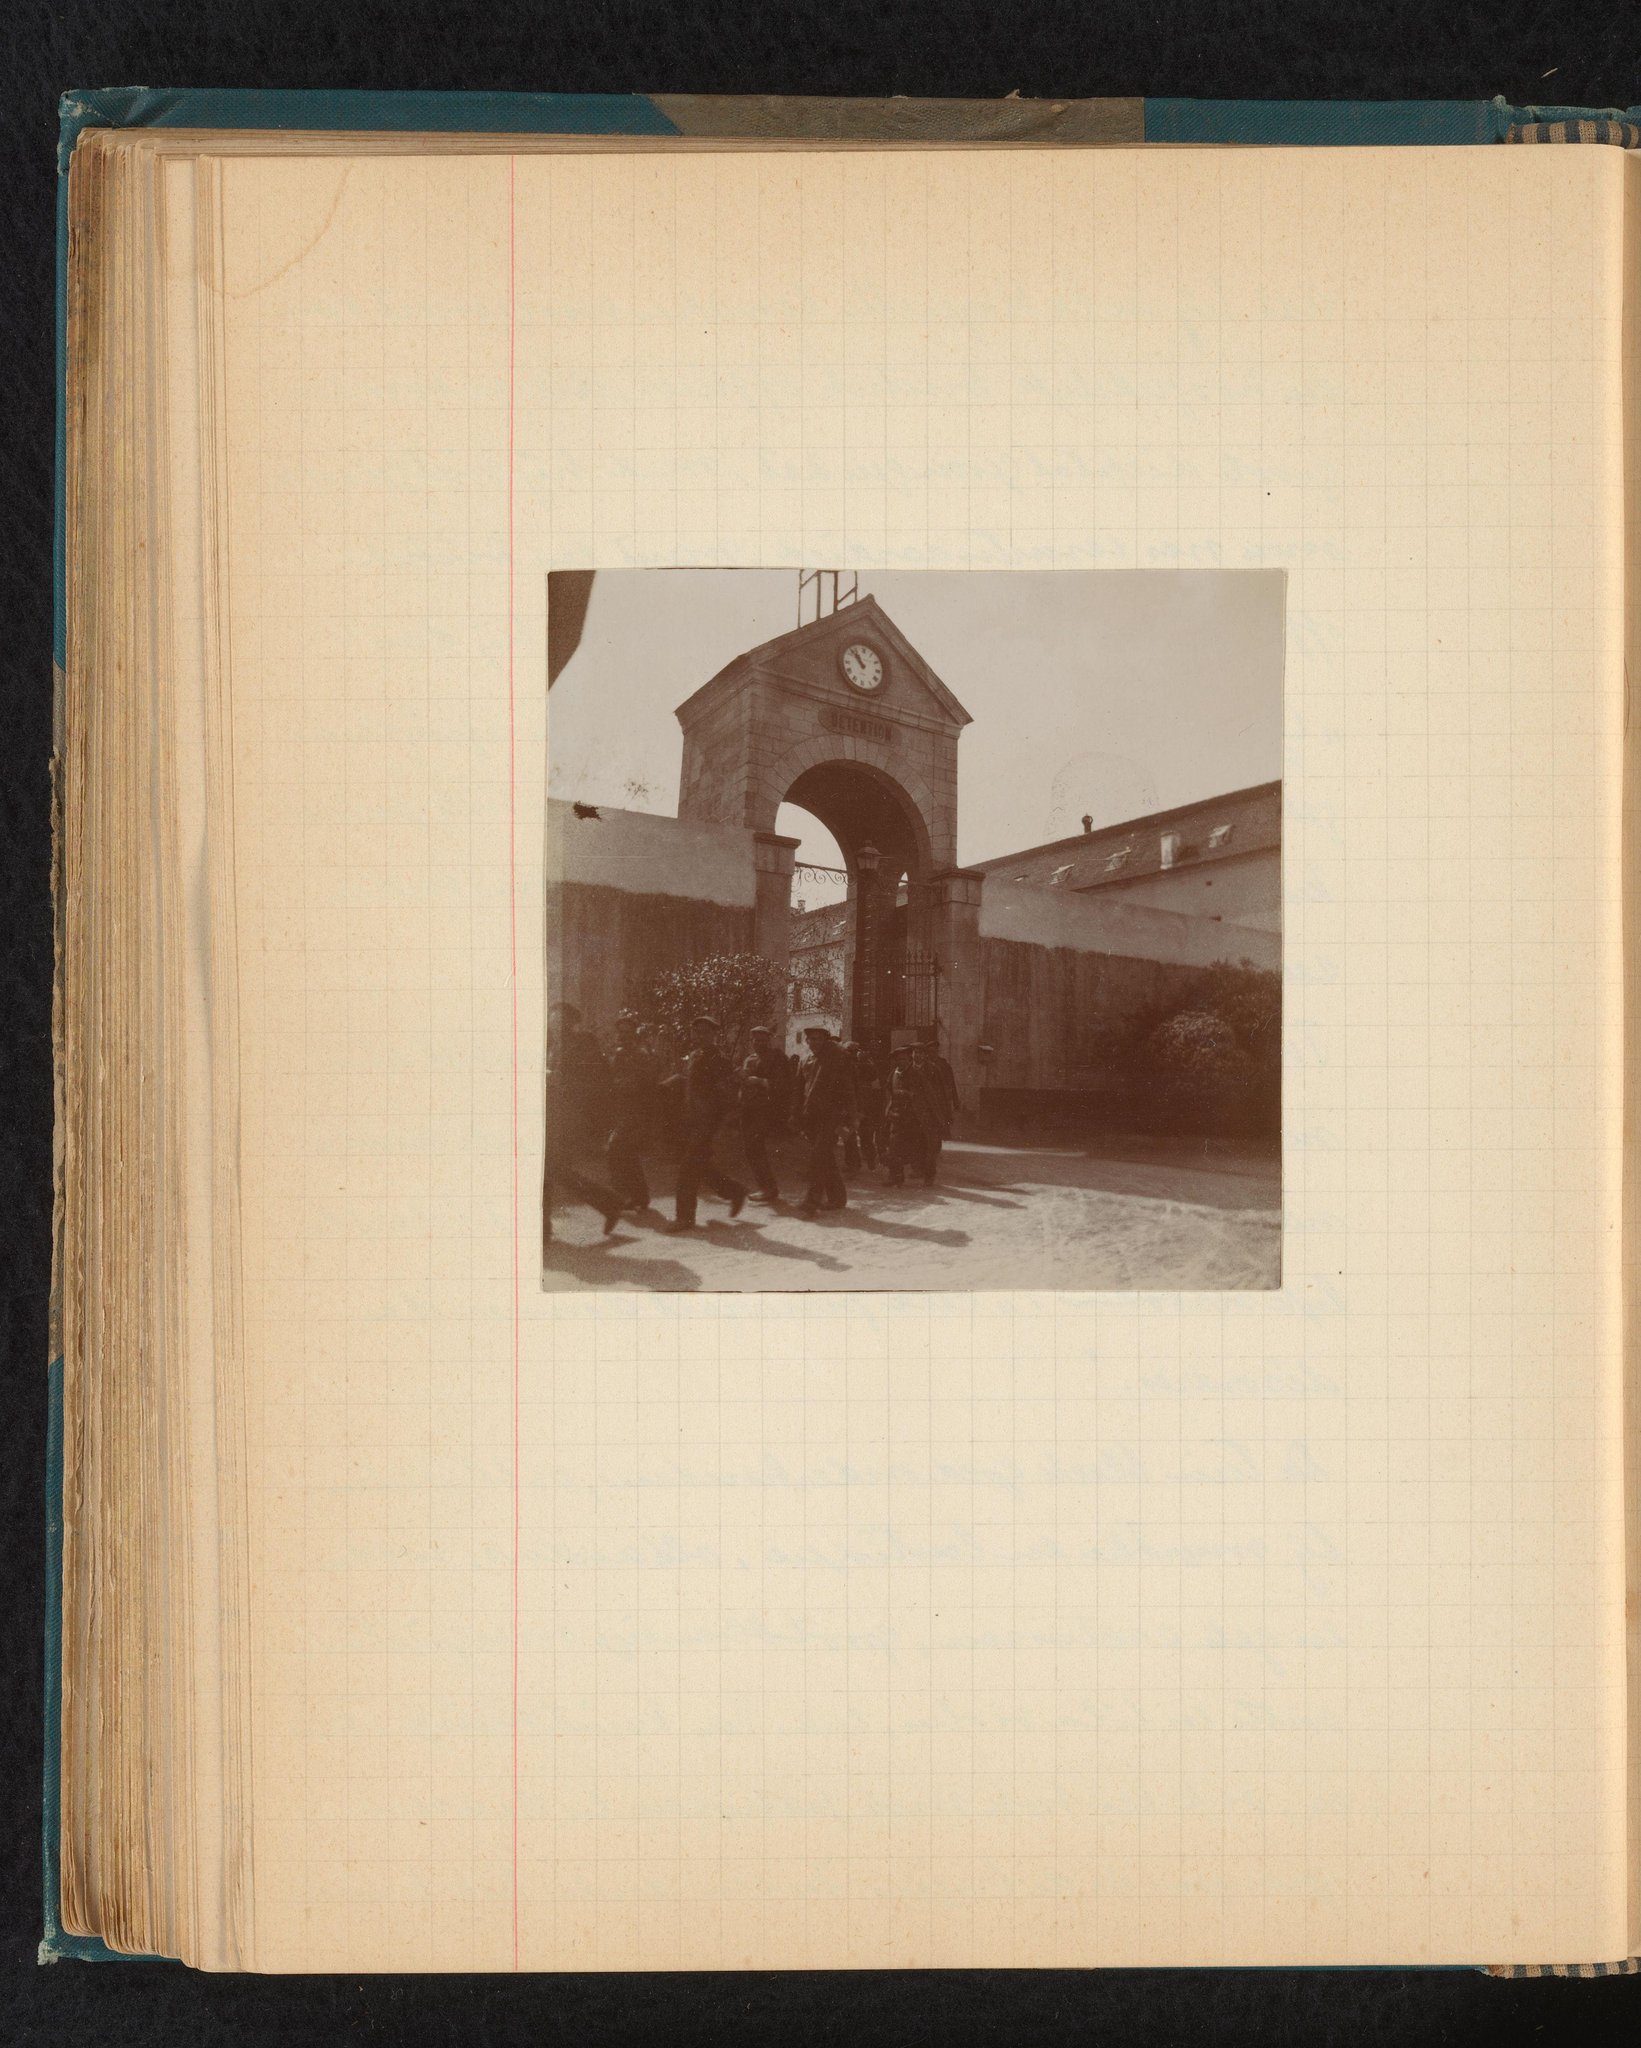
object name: photograph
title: Gevangenispoort met Arabische gevangenen, mogelijk in Chiavari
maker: théodore van lelyveld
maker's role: painter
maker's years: 1867-1954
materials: paper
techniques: daylight paper print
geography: chiavari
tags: prison, jail, gate, entrance, historical persons not known by name